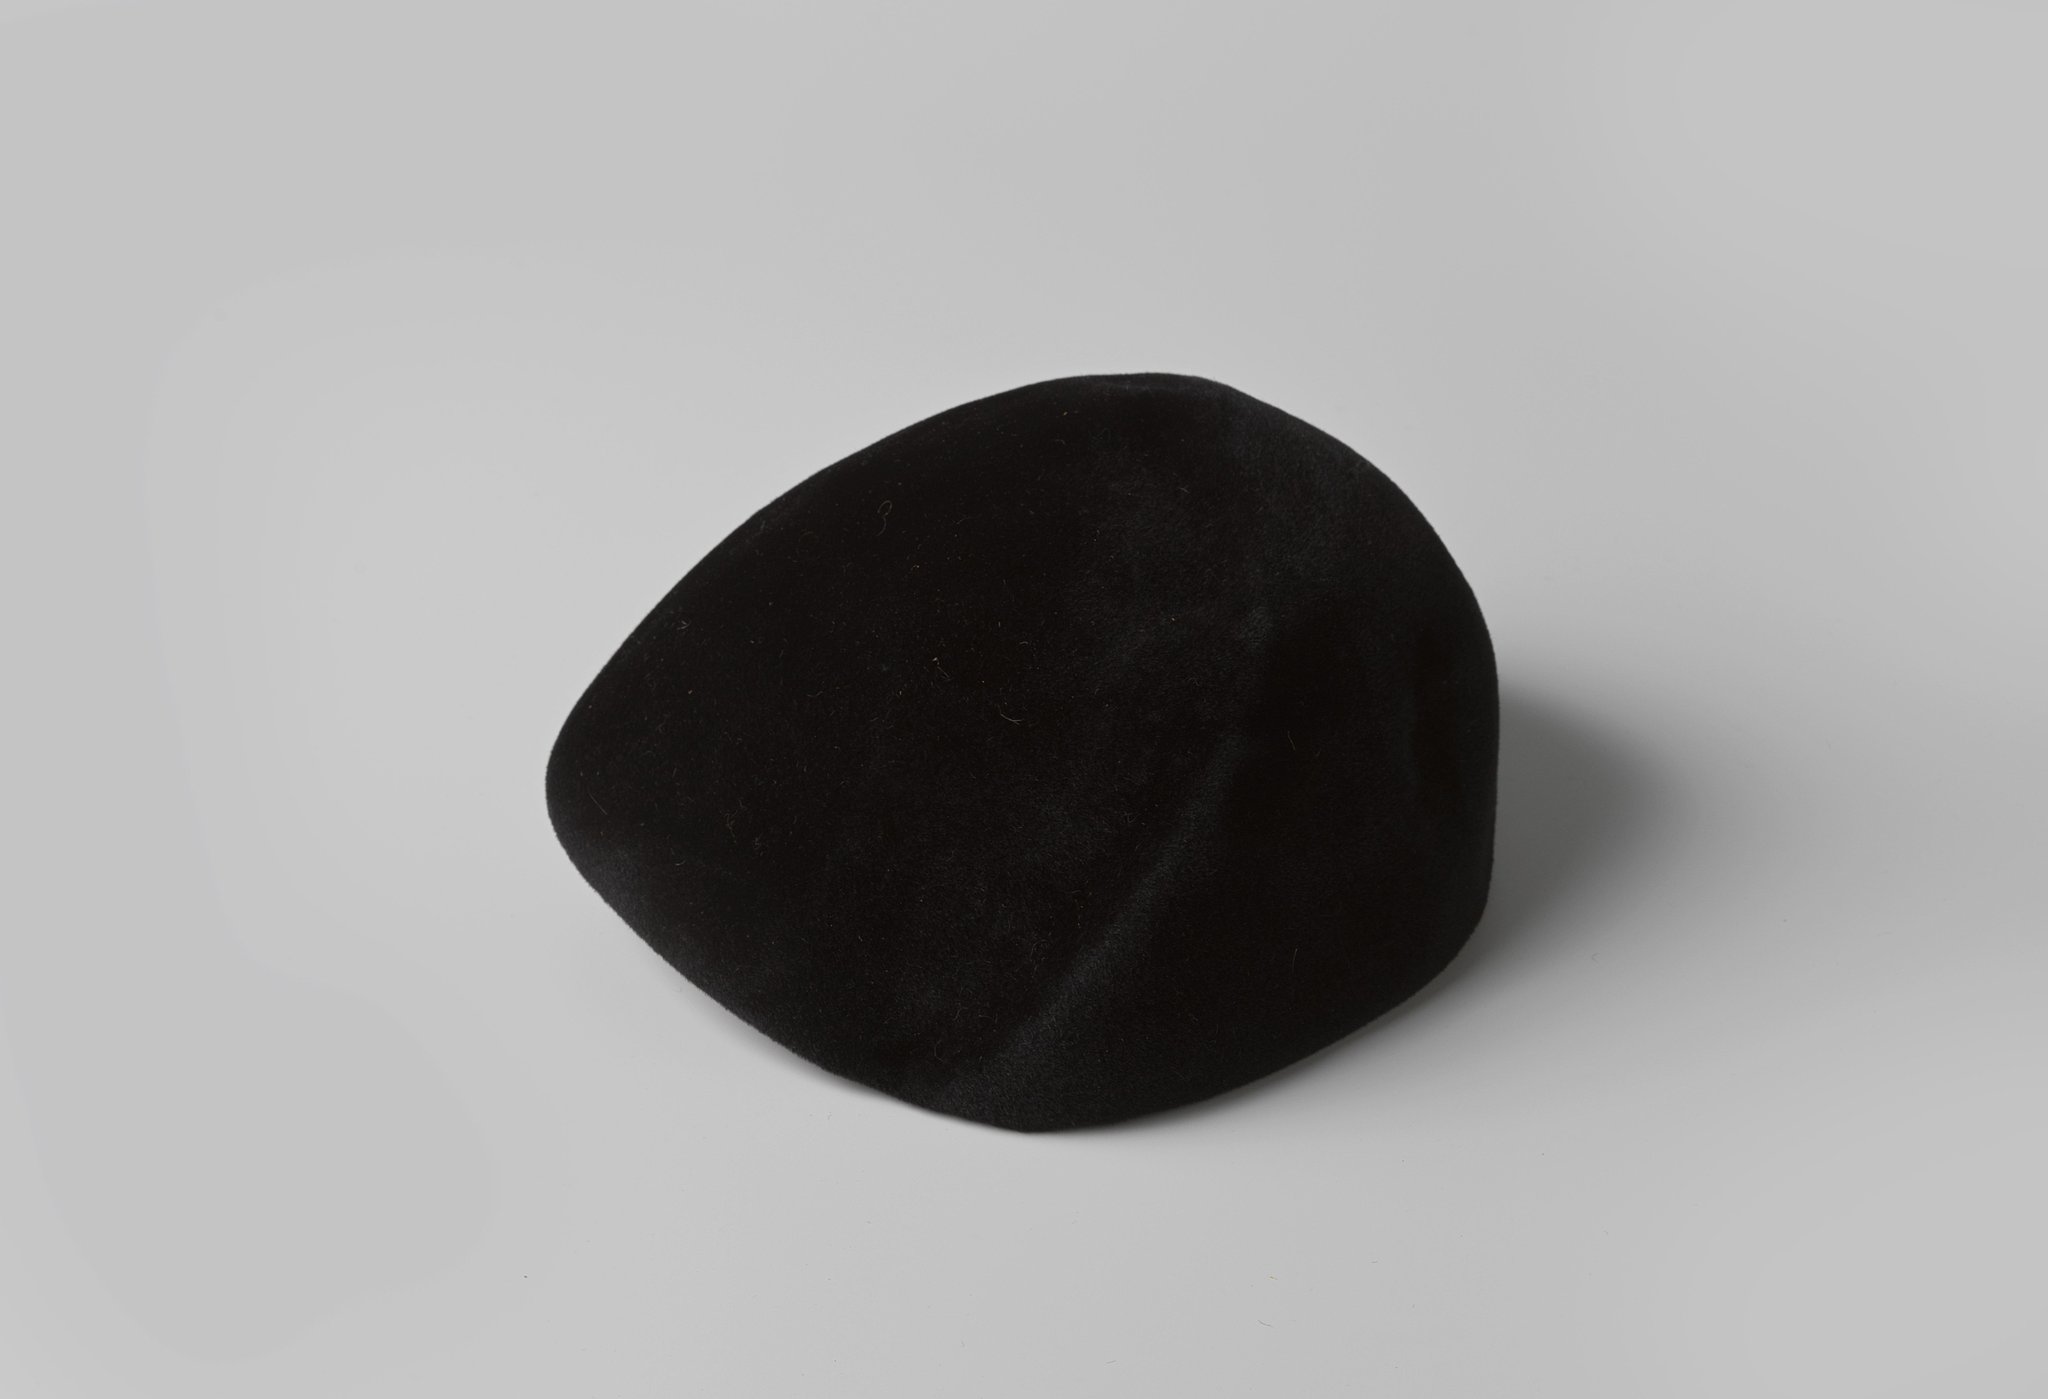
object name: hat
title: Hoed van zwart fluweelvilt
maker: angélique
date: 1950-1960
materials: felt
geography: haarlem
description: Hoed van zwart fluweelvilt. Ongevoerde slappe halve bol, de capeline weer naar binnen teruggevouwen tot de entrée. Met hoedenelastiekje. Adres: Angélique, en: Simons/HAARLEM/Speciaalzaak Dameshoeden/GEDEMPTE OUDE GRACHT 101.